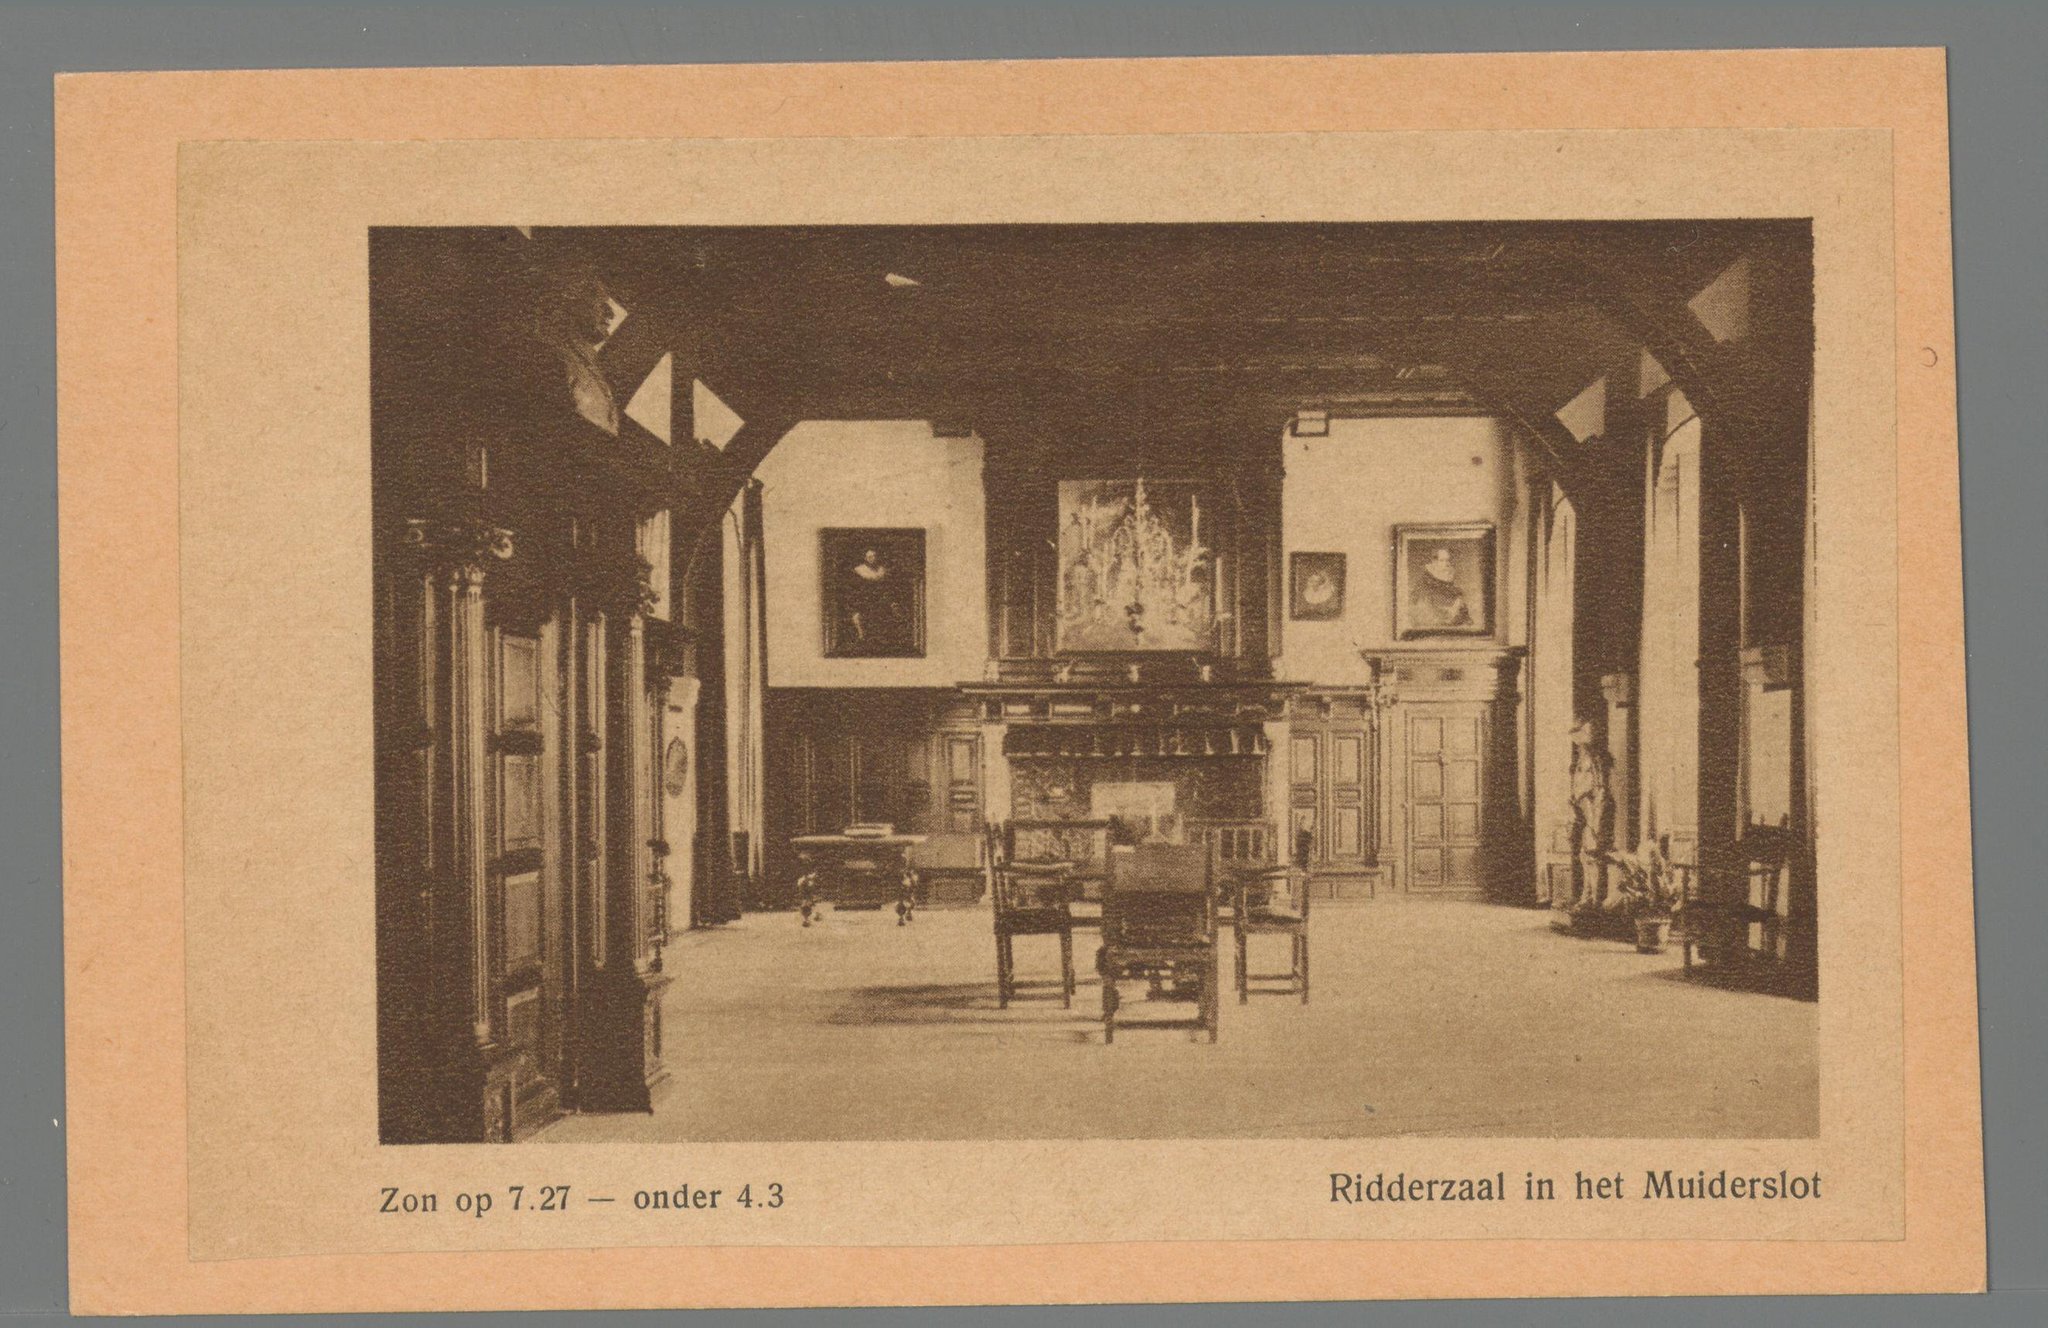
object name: photomechanical print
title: Ridderzaal in het Muiderslot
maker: Anonymous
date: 1895-1930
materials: cardboard, paper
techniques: rotogravure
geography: muiden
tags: castle - aa - civic architecture: inside